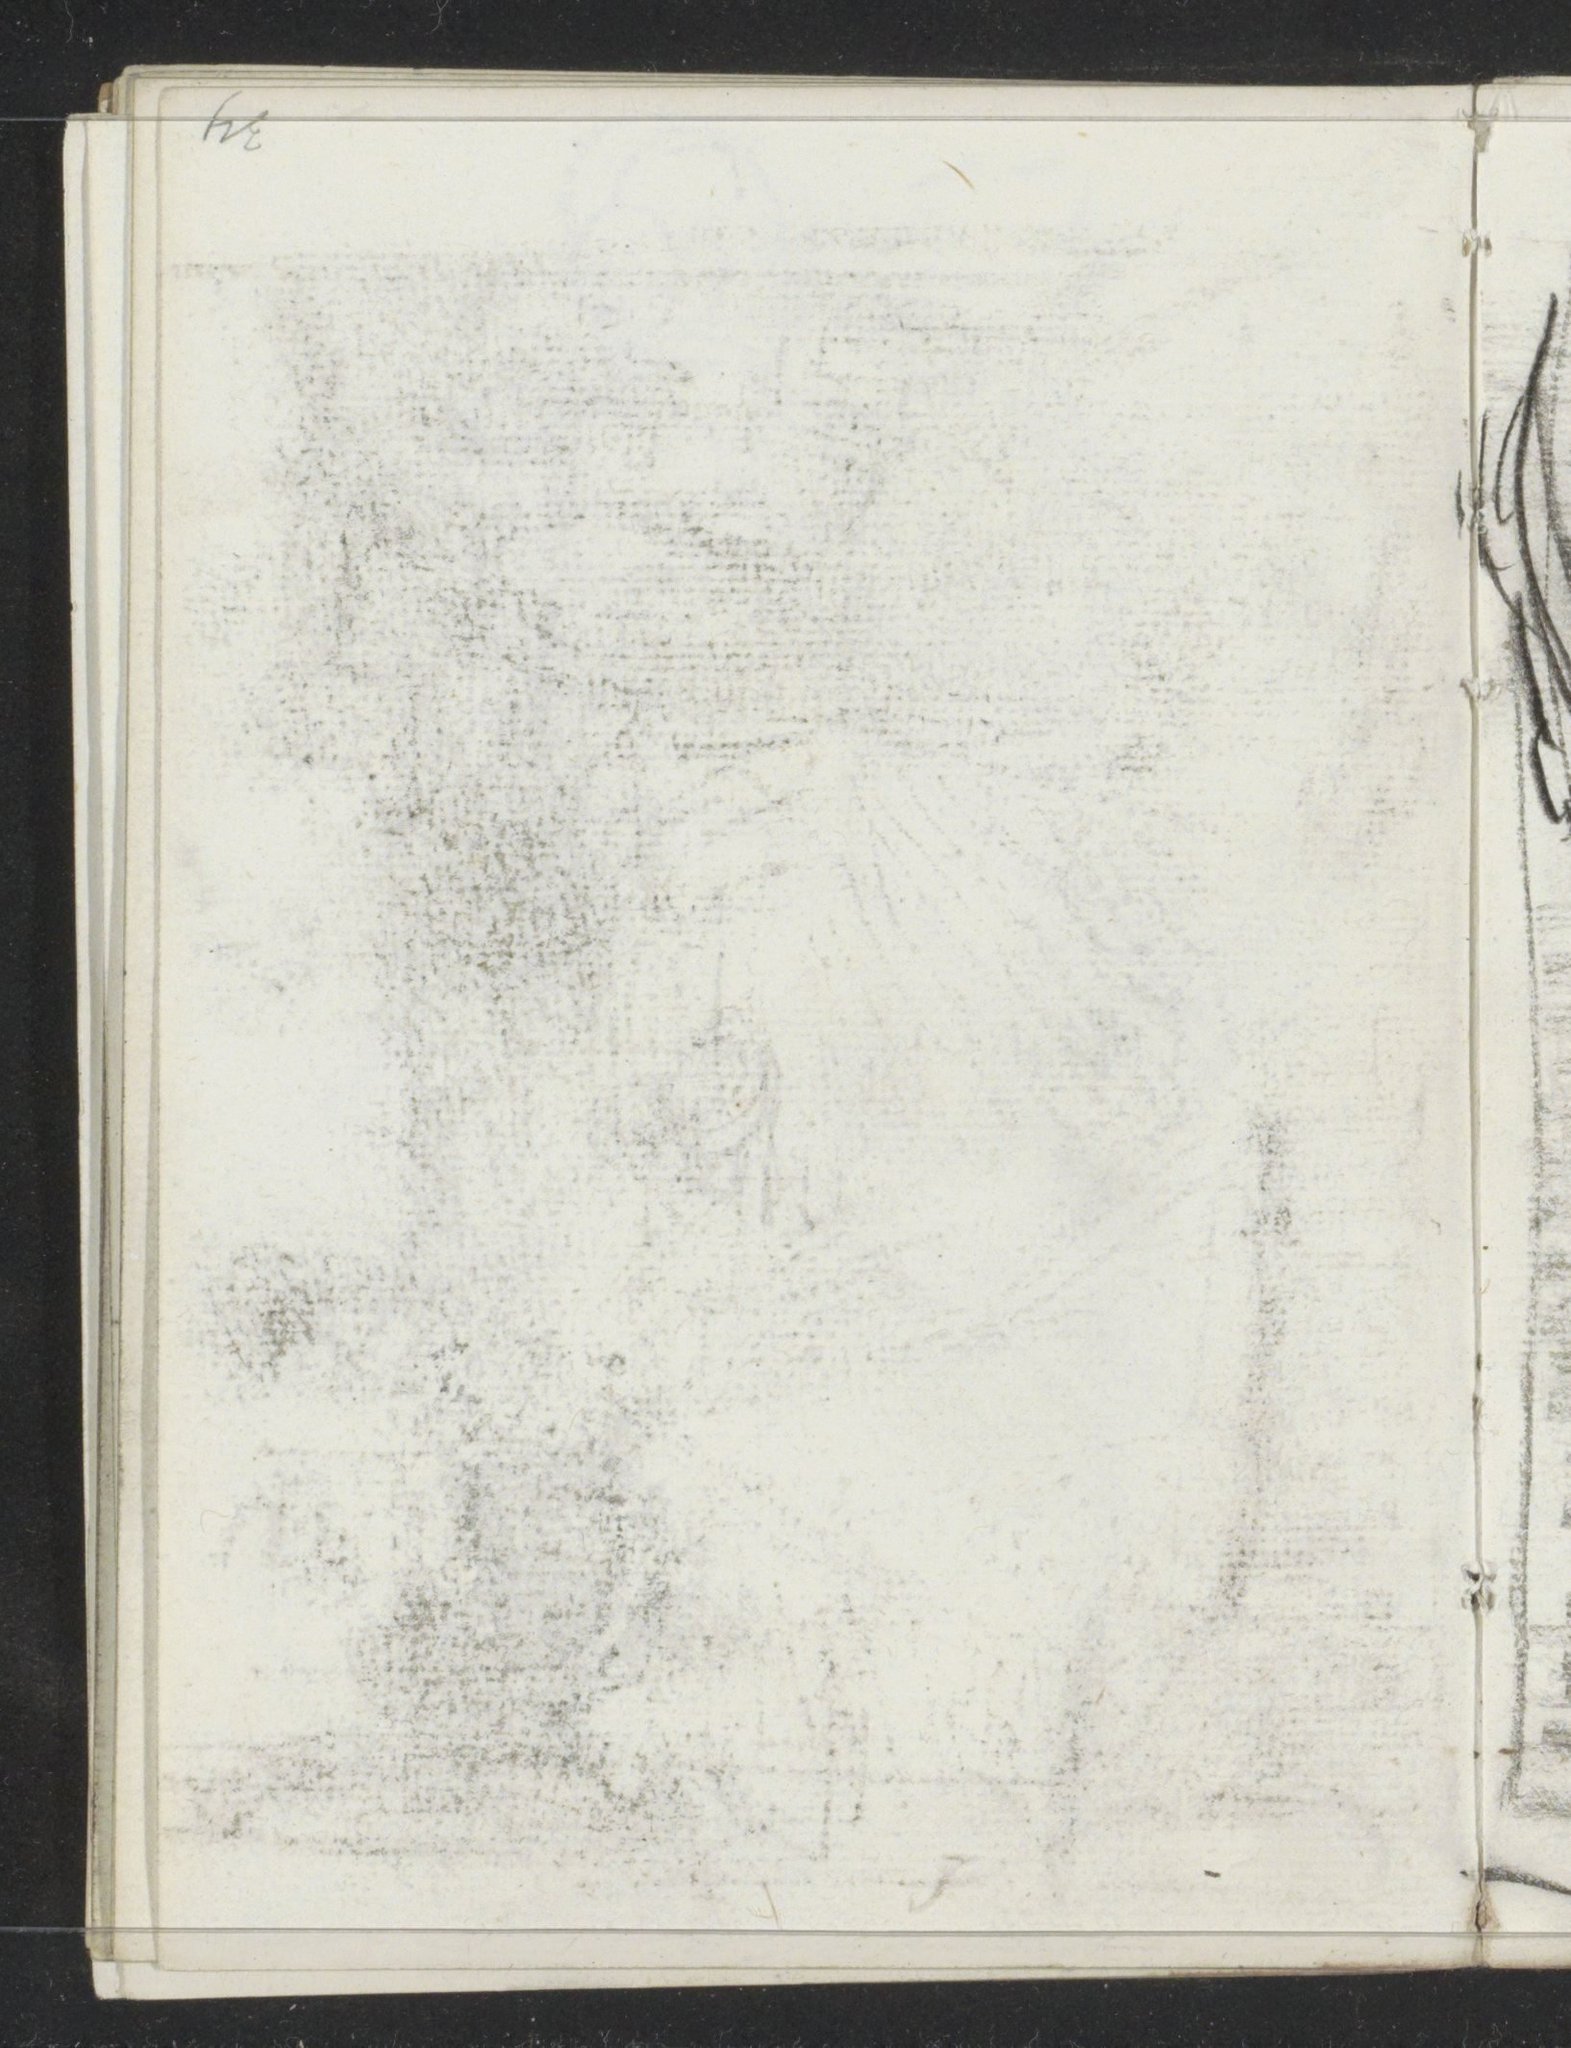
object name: sketchbook leaf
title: Abklatsch van de krijttekening op blad 14 recto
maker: isaac israels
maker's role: draughtsman, painter, print maker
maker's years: 1865-1934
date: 1886-1934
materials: paper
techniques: printmaking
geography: amsterdam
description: Blad 13 verso uit schetsboek LXIII met 23 bladen.